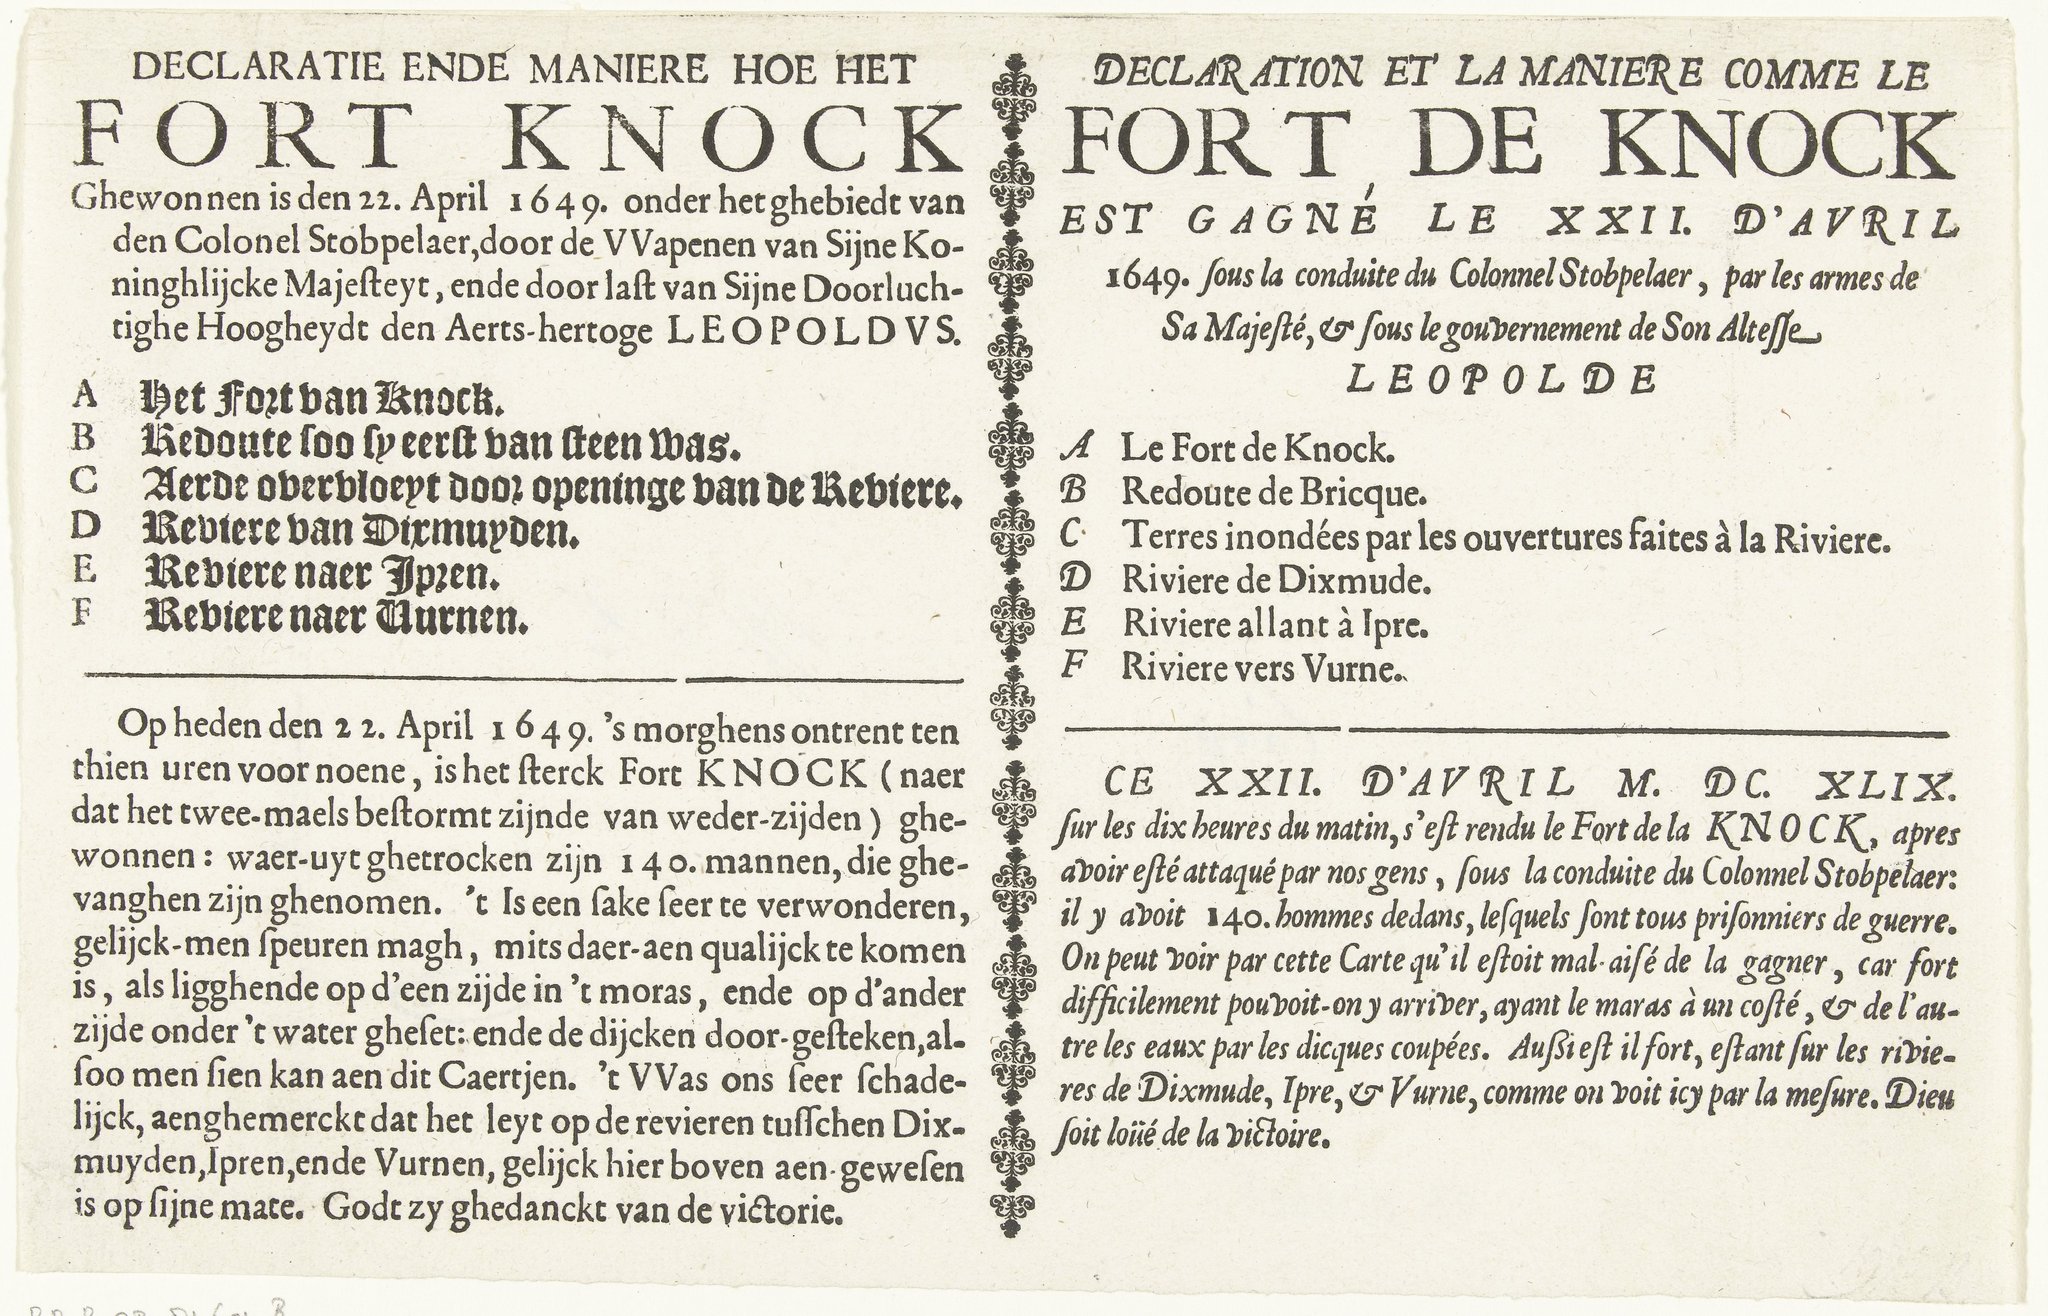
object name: text sheet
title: Declaratie ende maniere hoe het Fort Knock Ghewonnen is den 22. April 1649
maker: Anonymous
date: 1649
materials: paper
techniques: letterpress printing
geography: southern netherlands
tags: vienna, leopold willem van oostenrijk (landvoogd der zuidelijke nederlanden)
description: Tekstblad bij de kaart met de inname van Fort Knokke op 22 april 1649 door het leger van de landvoogd Leopold Willem. Tekst in twee kolommen in het Nederlands en Frans, met de legenda A-F.